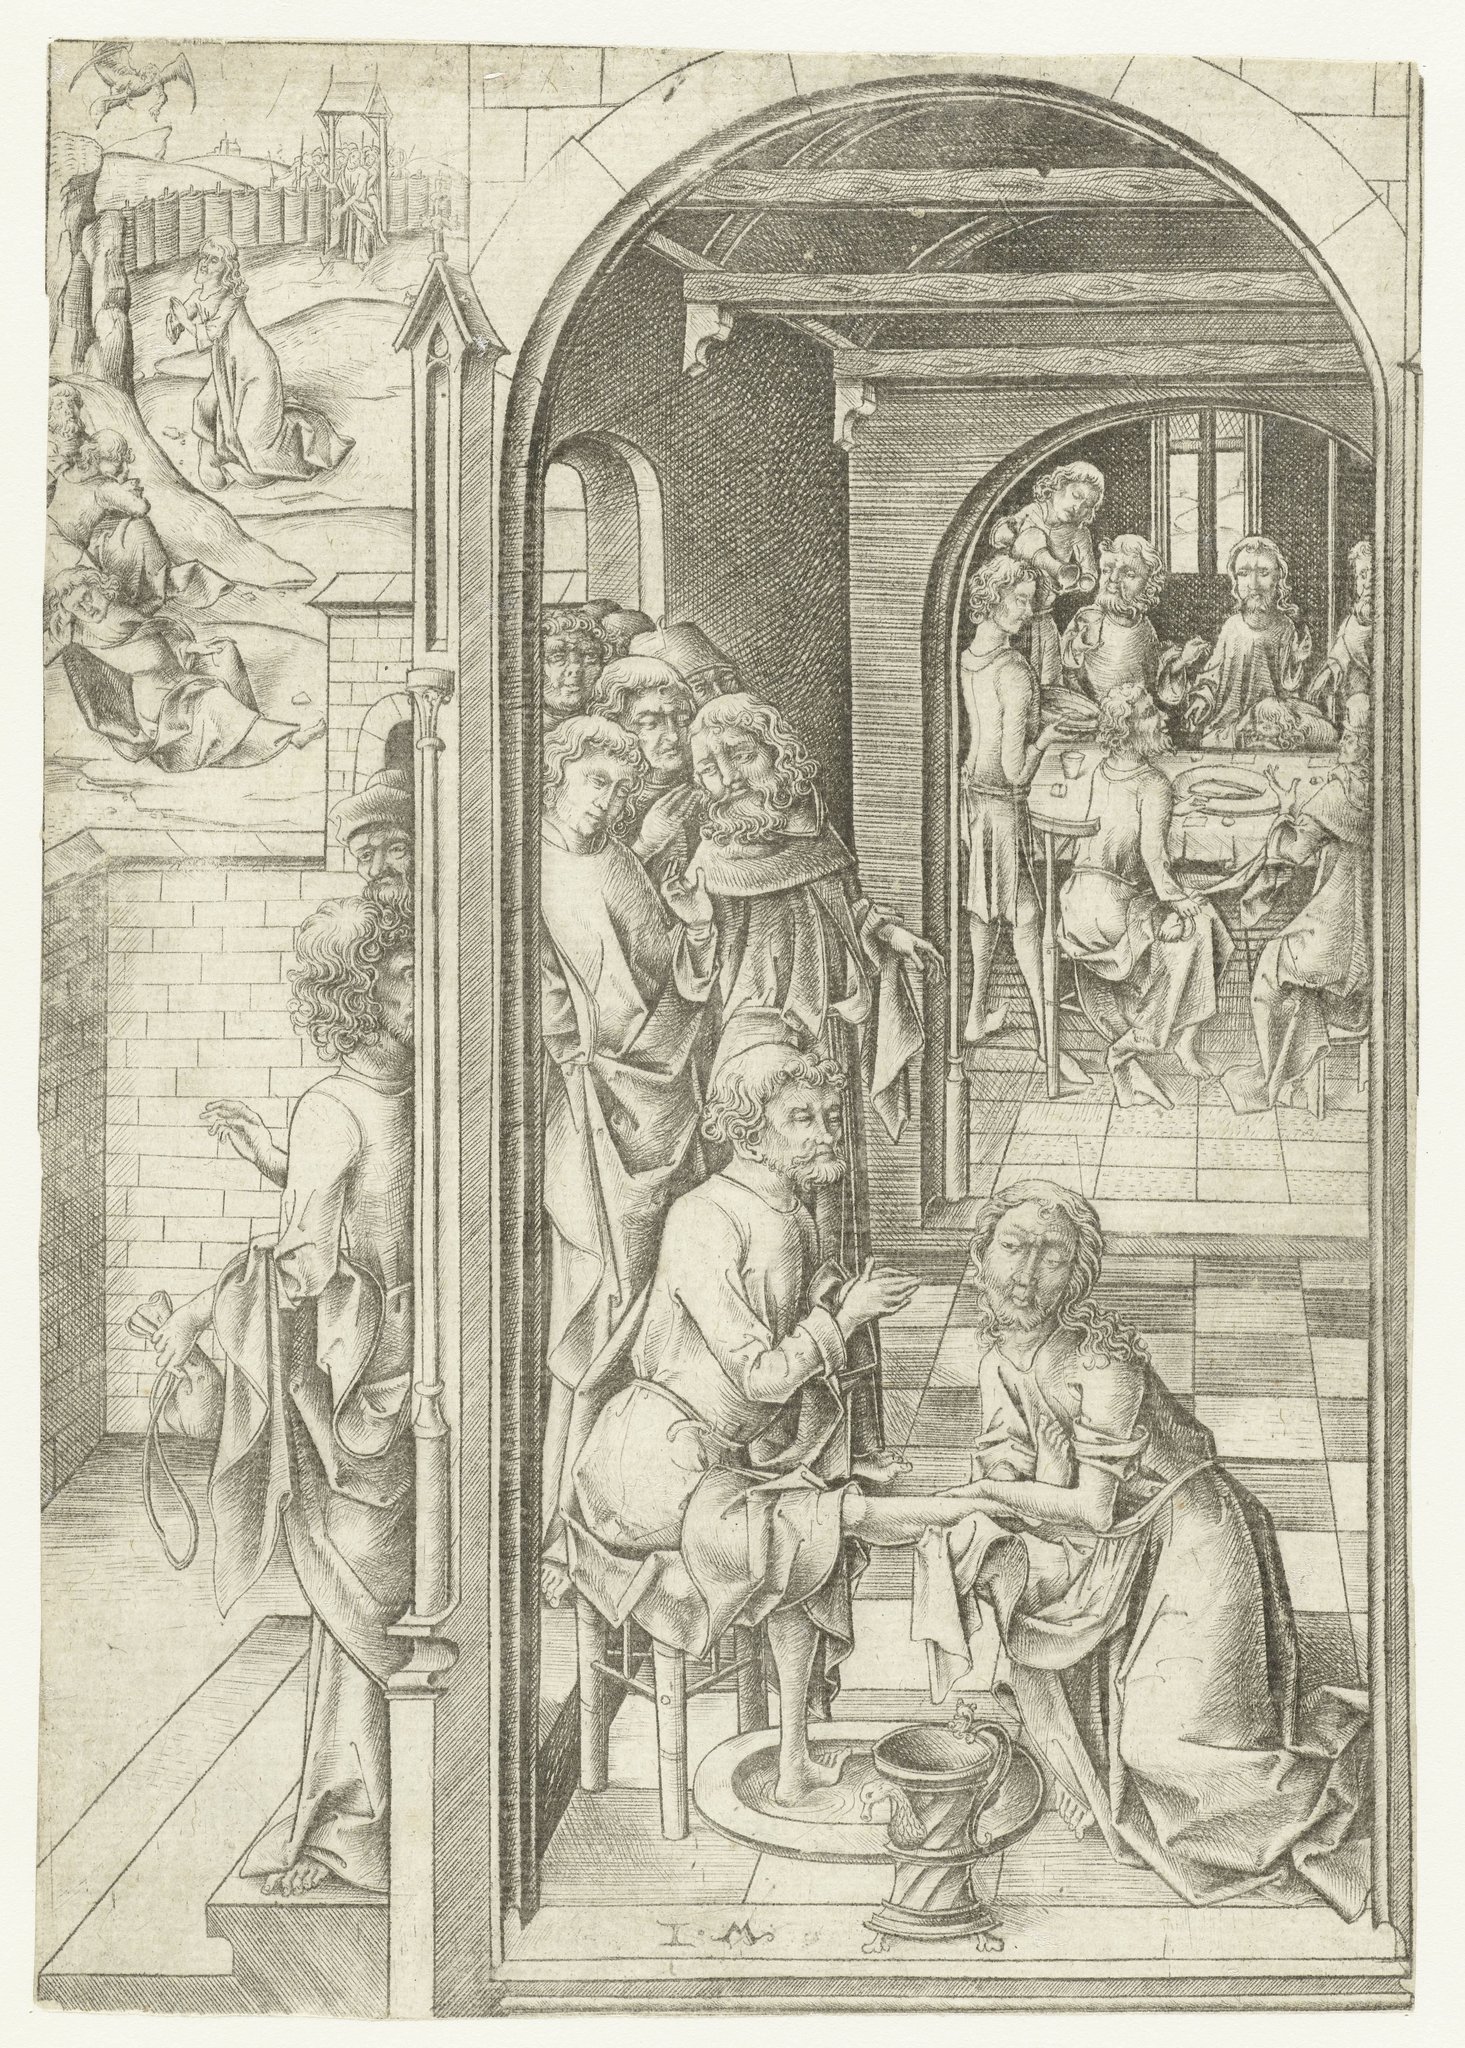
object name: print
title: De voetwassing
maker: israhel van meckenem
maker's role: print maker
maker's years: 1440-1517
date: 1455-1503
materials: paper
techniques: engraving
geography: bocholt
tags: christ washes peter's feet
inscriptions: collector's mark: Lugt 2228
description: Christus wast de voeten van de discipel Petrus. De andere discipelen staan erbij. Op de achtergrond rechts het Laatste Avondmaal. Op de achtergrond links Christus in de hof van Getsemane. Deze prent is onderdeel van een serie van twaalf prenten met scènes uit het Lijdensverhaal.